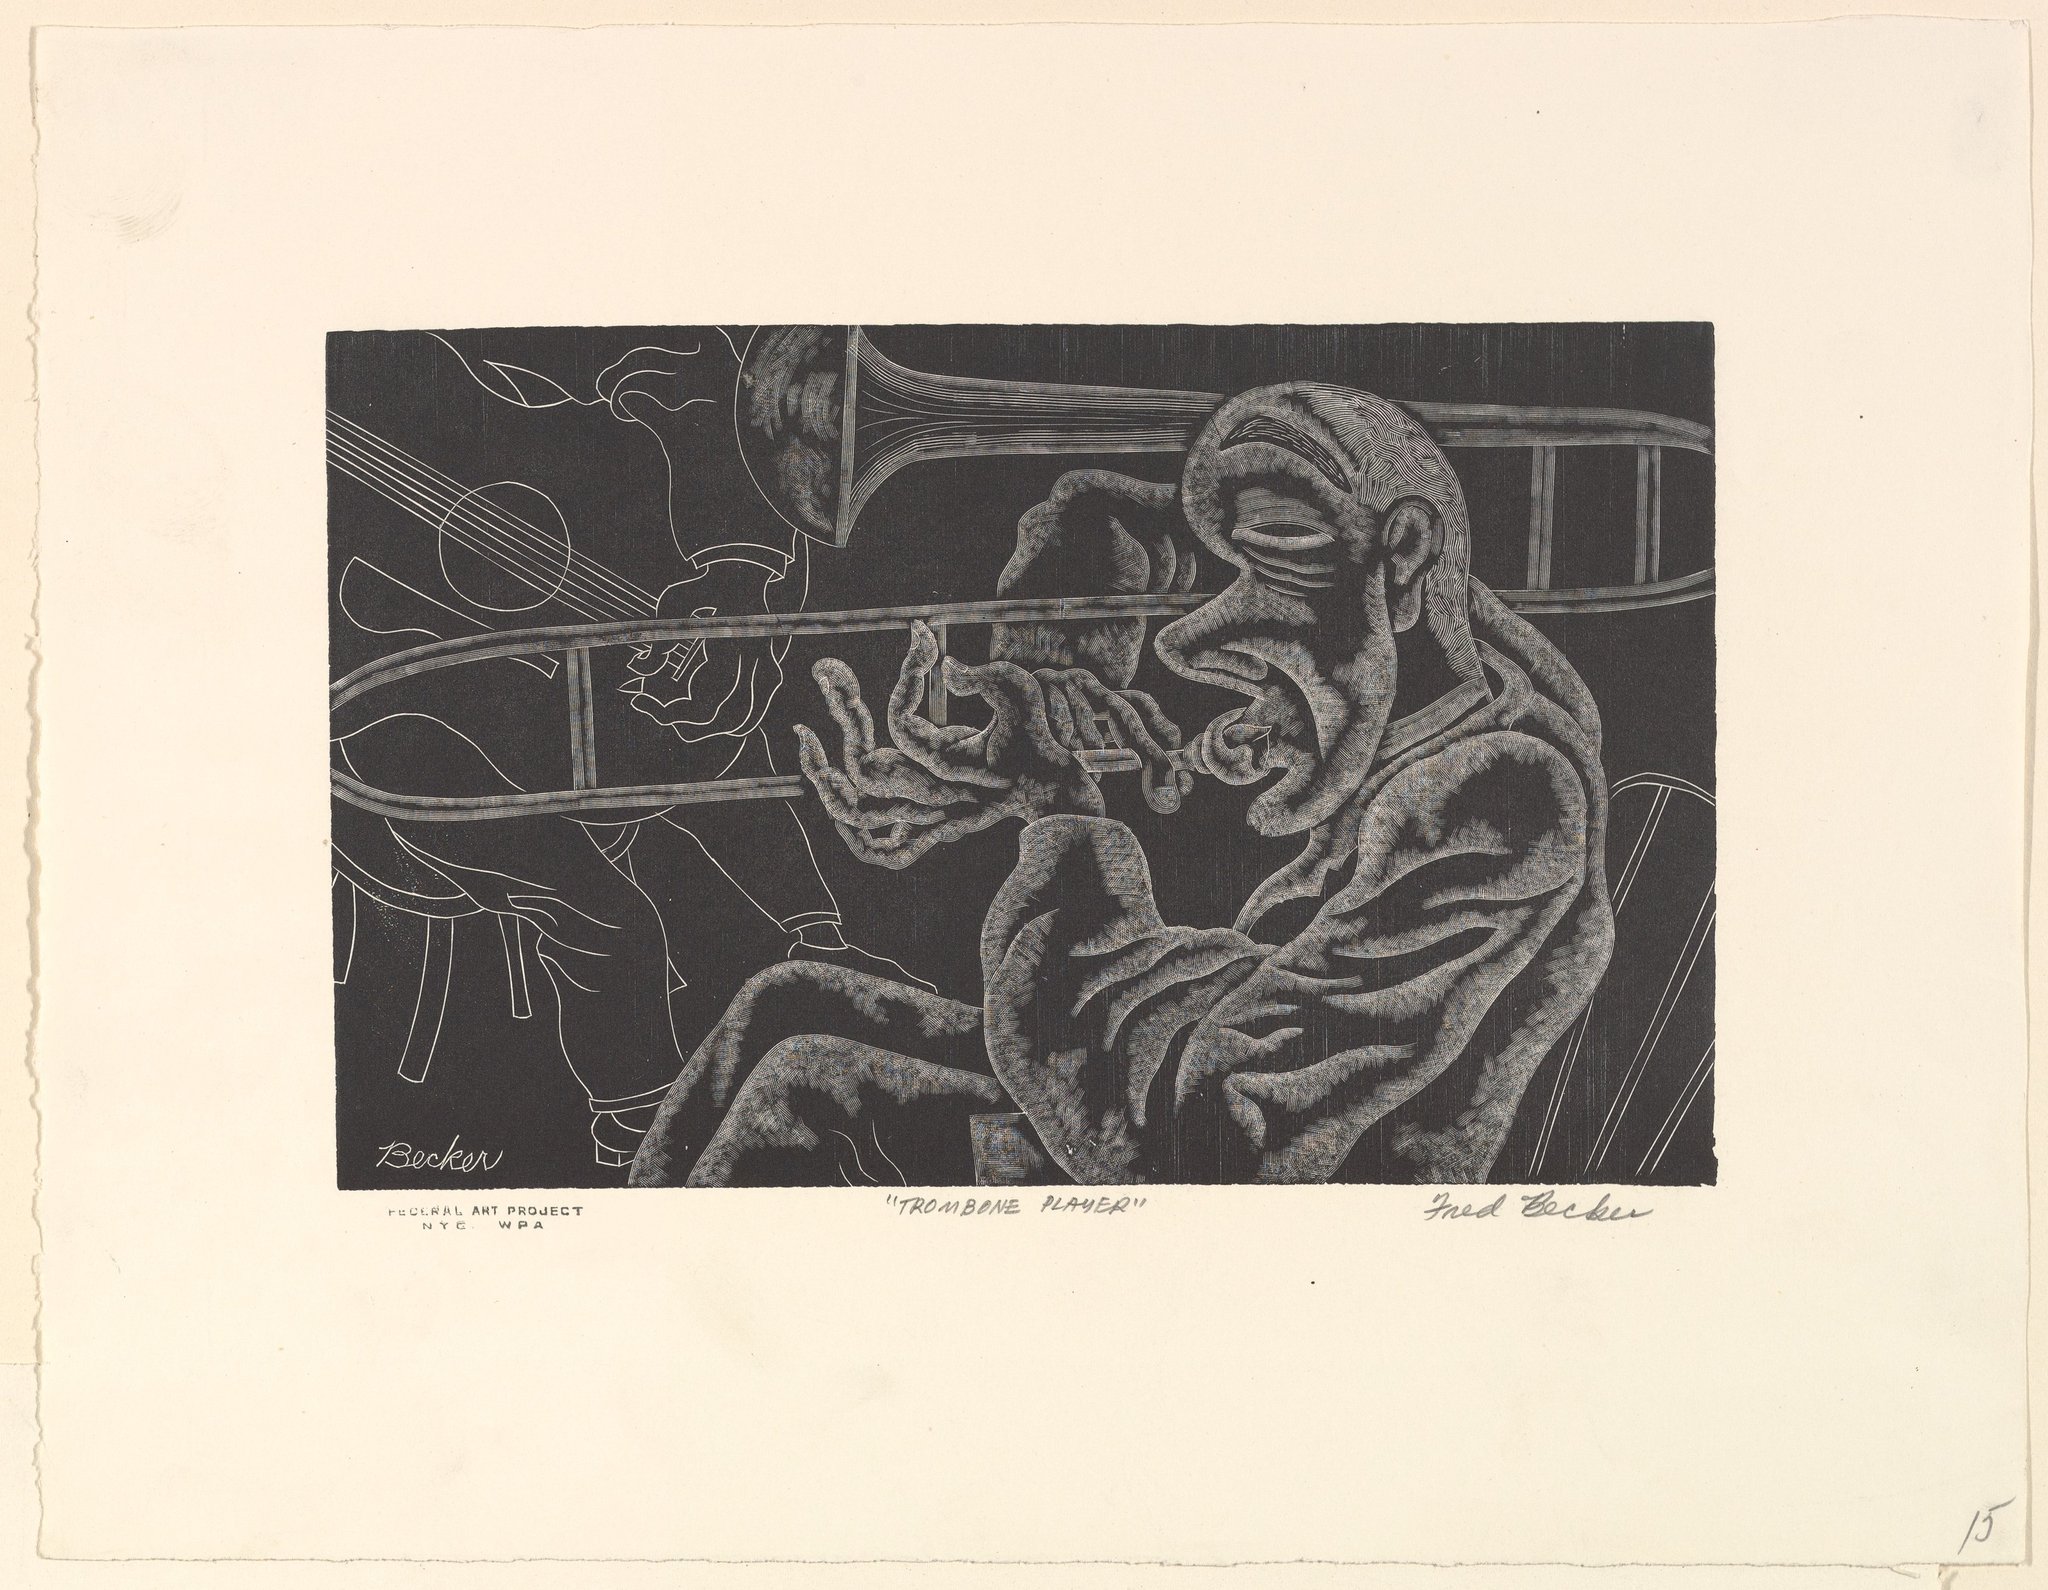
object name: print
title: Trombone Player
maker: fred becker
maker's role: artist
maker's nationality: american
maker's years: 1913-2004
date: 1935-1940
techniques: engraving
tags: men,trombones,musicians